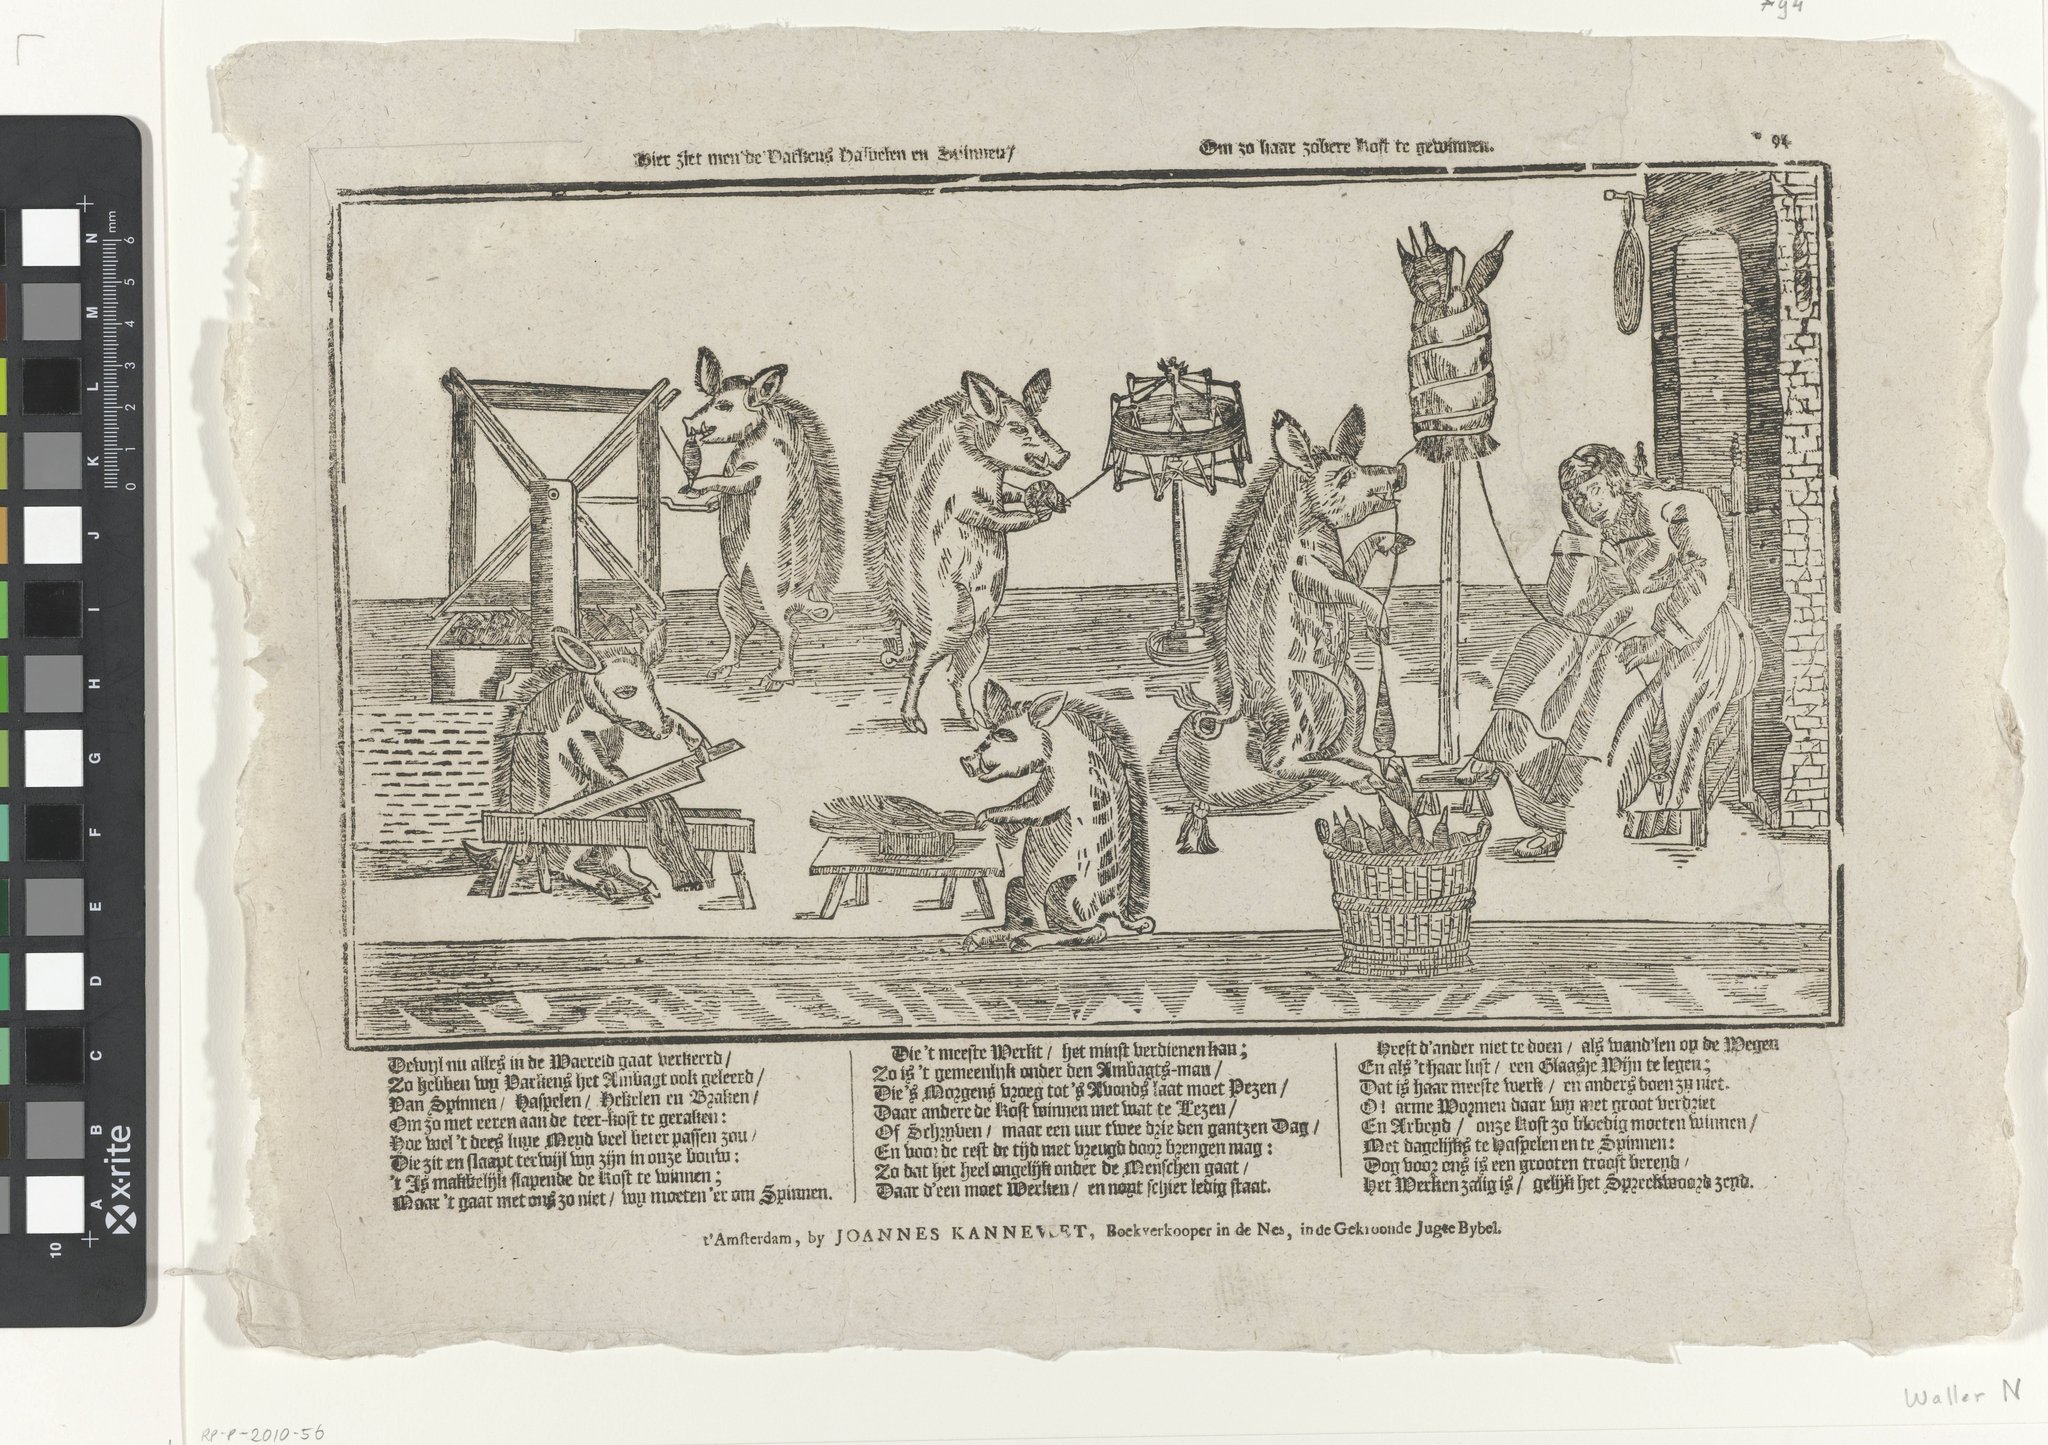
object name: print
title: Hier ziet men de varkens haspelen en spinnen / Om zo haar zobere kost te gewinnen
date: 1725-1780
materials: paper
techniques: letterpress printing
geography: amsterdam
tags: boar (male pig), animals acting as human beings, hoofed animals: boar, spinning (manufacture of yarn)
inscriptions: collector's mark: Lugt 2228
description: Blad met een grote voorstelling van zwijnen die zich als mensen gedragen en garen spinnen en haspelen. Onder de afbeelding een vers in drie kolommen. Genummerd rechtsboven: *94.